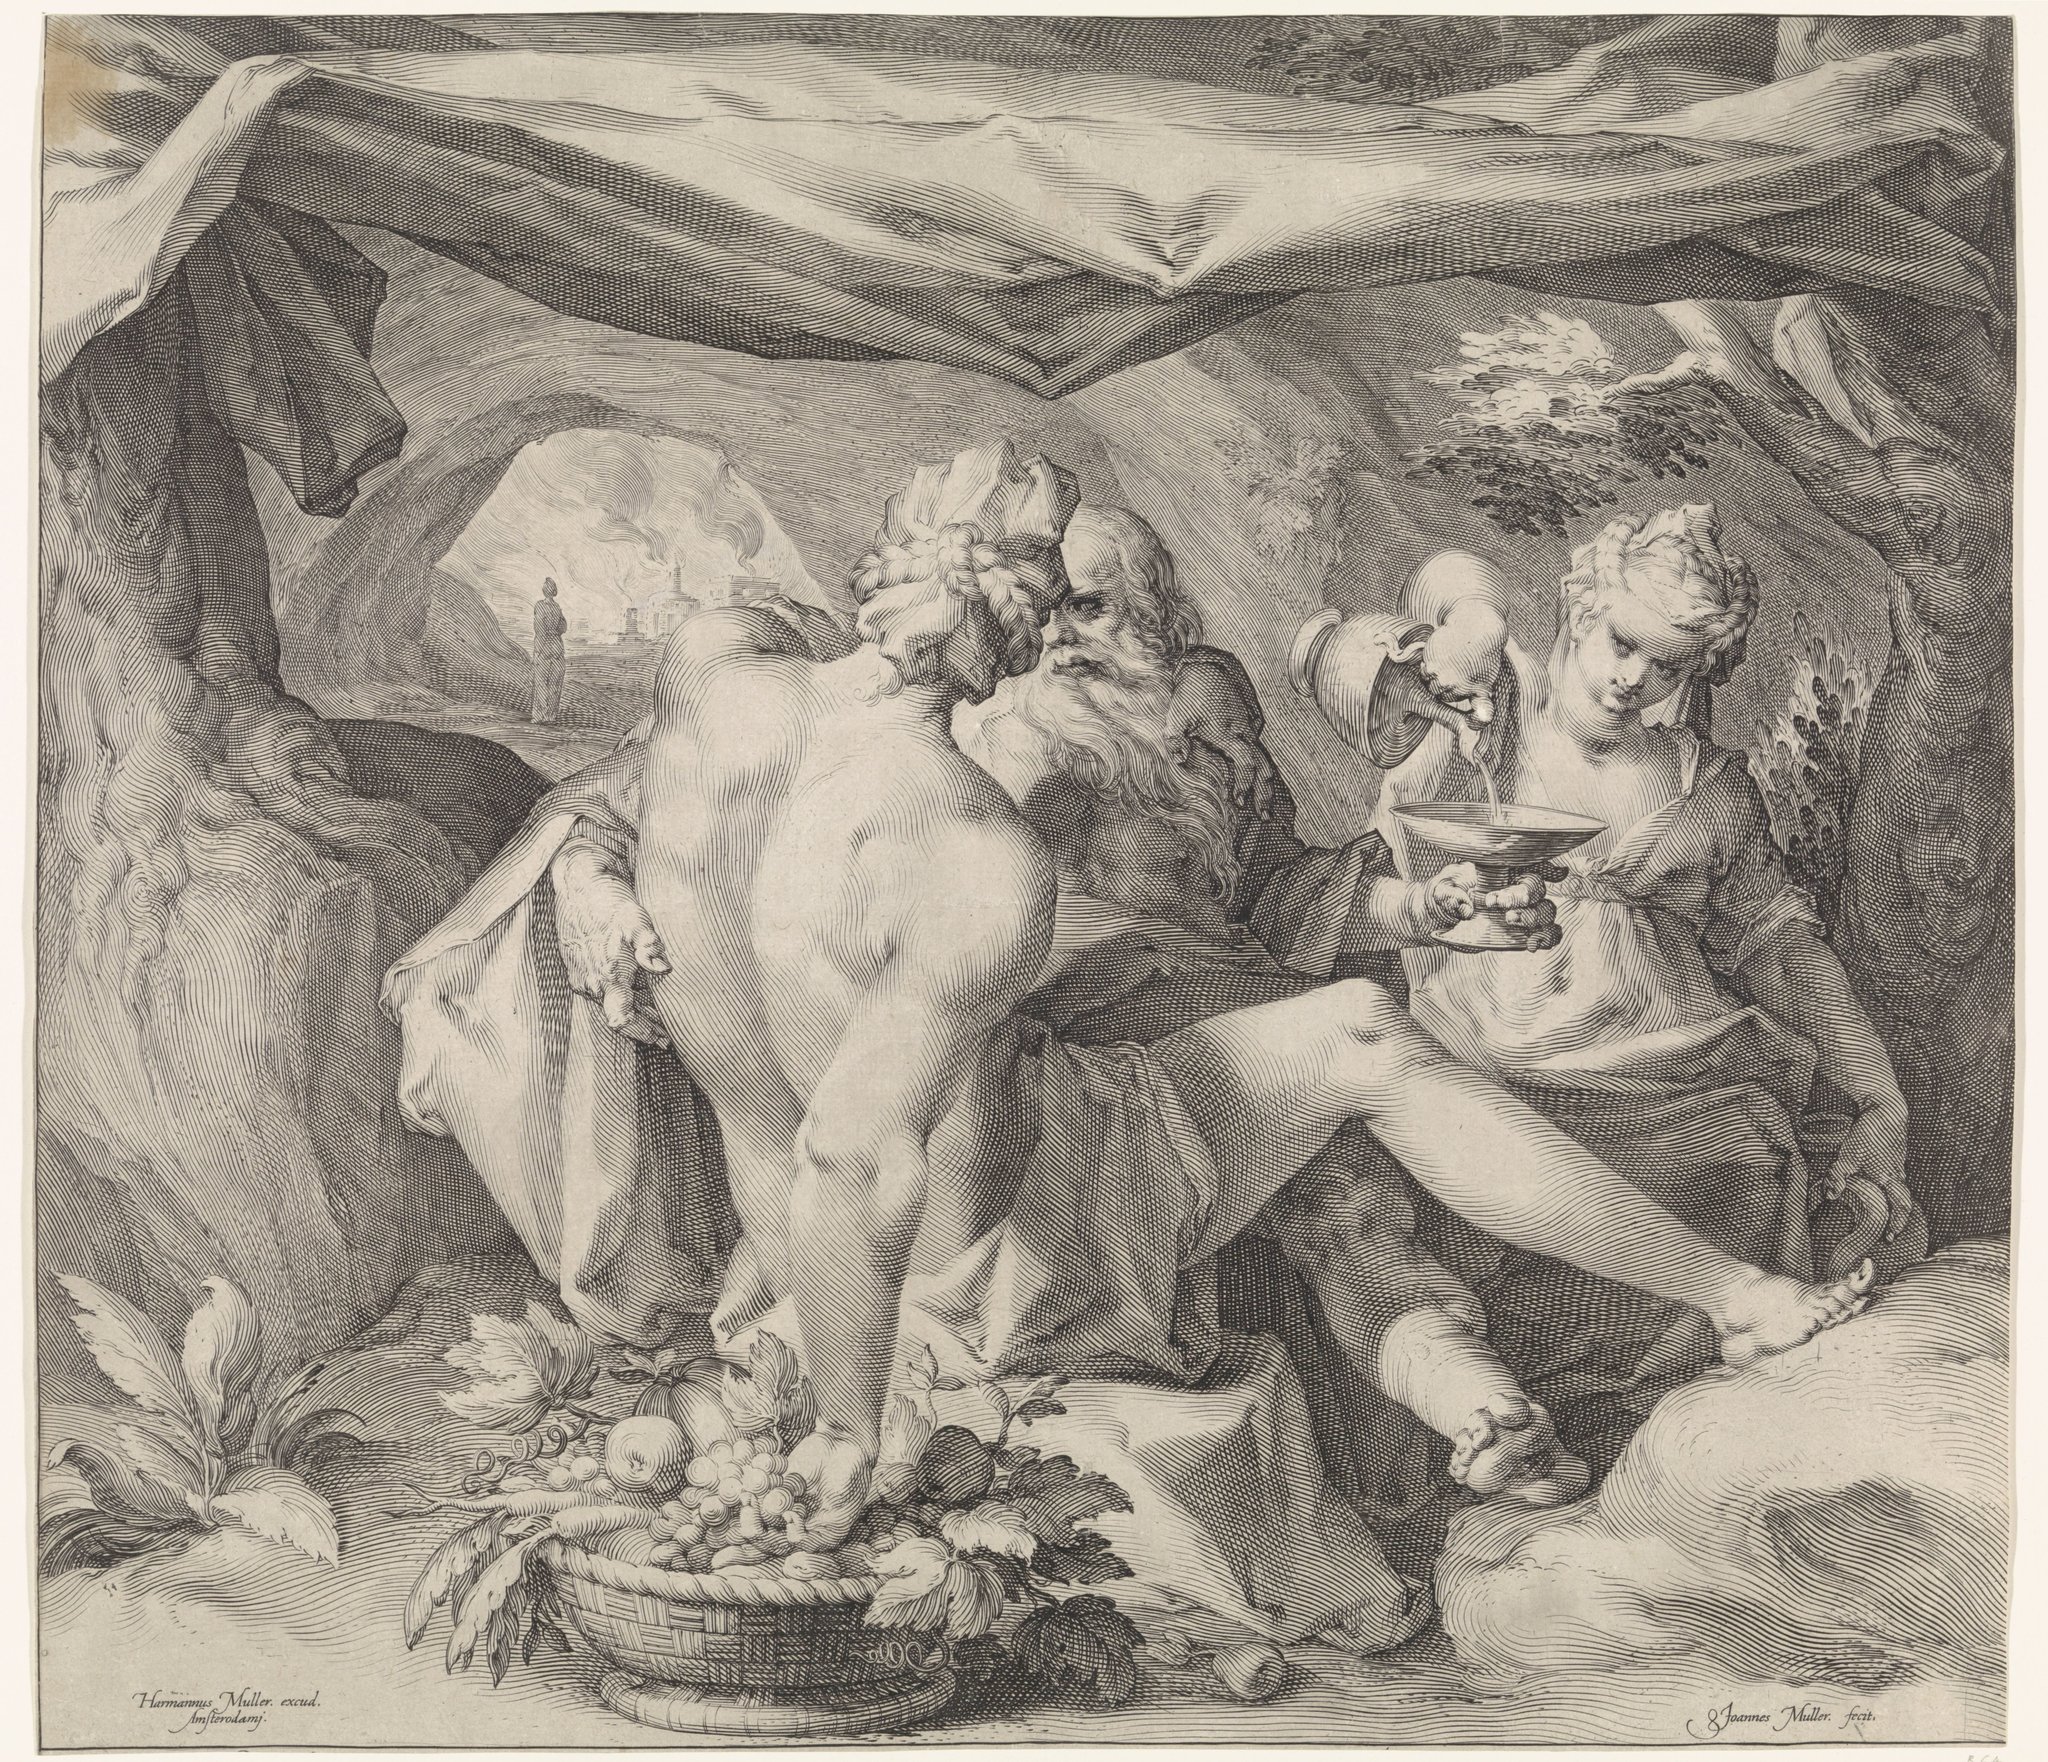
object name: print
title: Lot en zijn dochters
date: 1598-1602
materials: paper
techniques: engraving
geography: amsterdam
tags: lot and his daughters (genesis 19:30-38)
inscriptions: collector's mark: Lugt 240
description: Lot zit met zijn dochters in een grot en wordt door hen dronken gevoerd. Op de achtergrond de brandende steden Sodom en Gomorra en de vrouw van Lot als zoutpilaar.